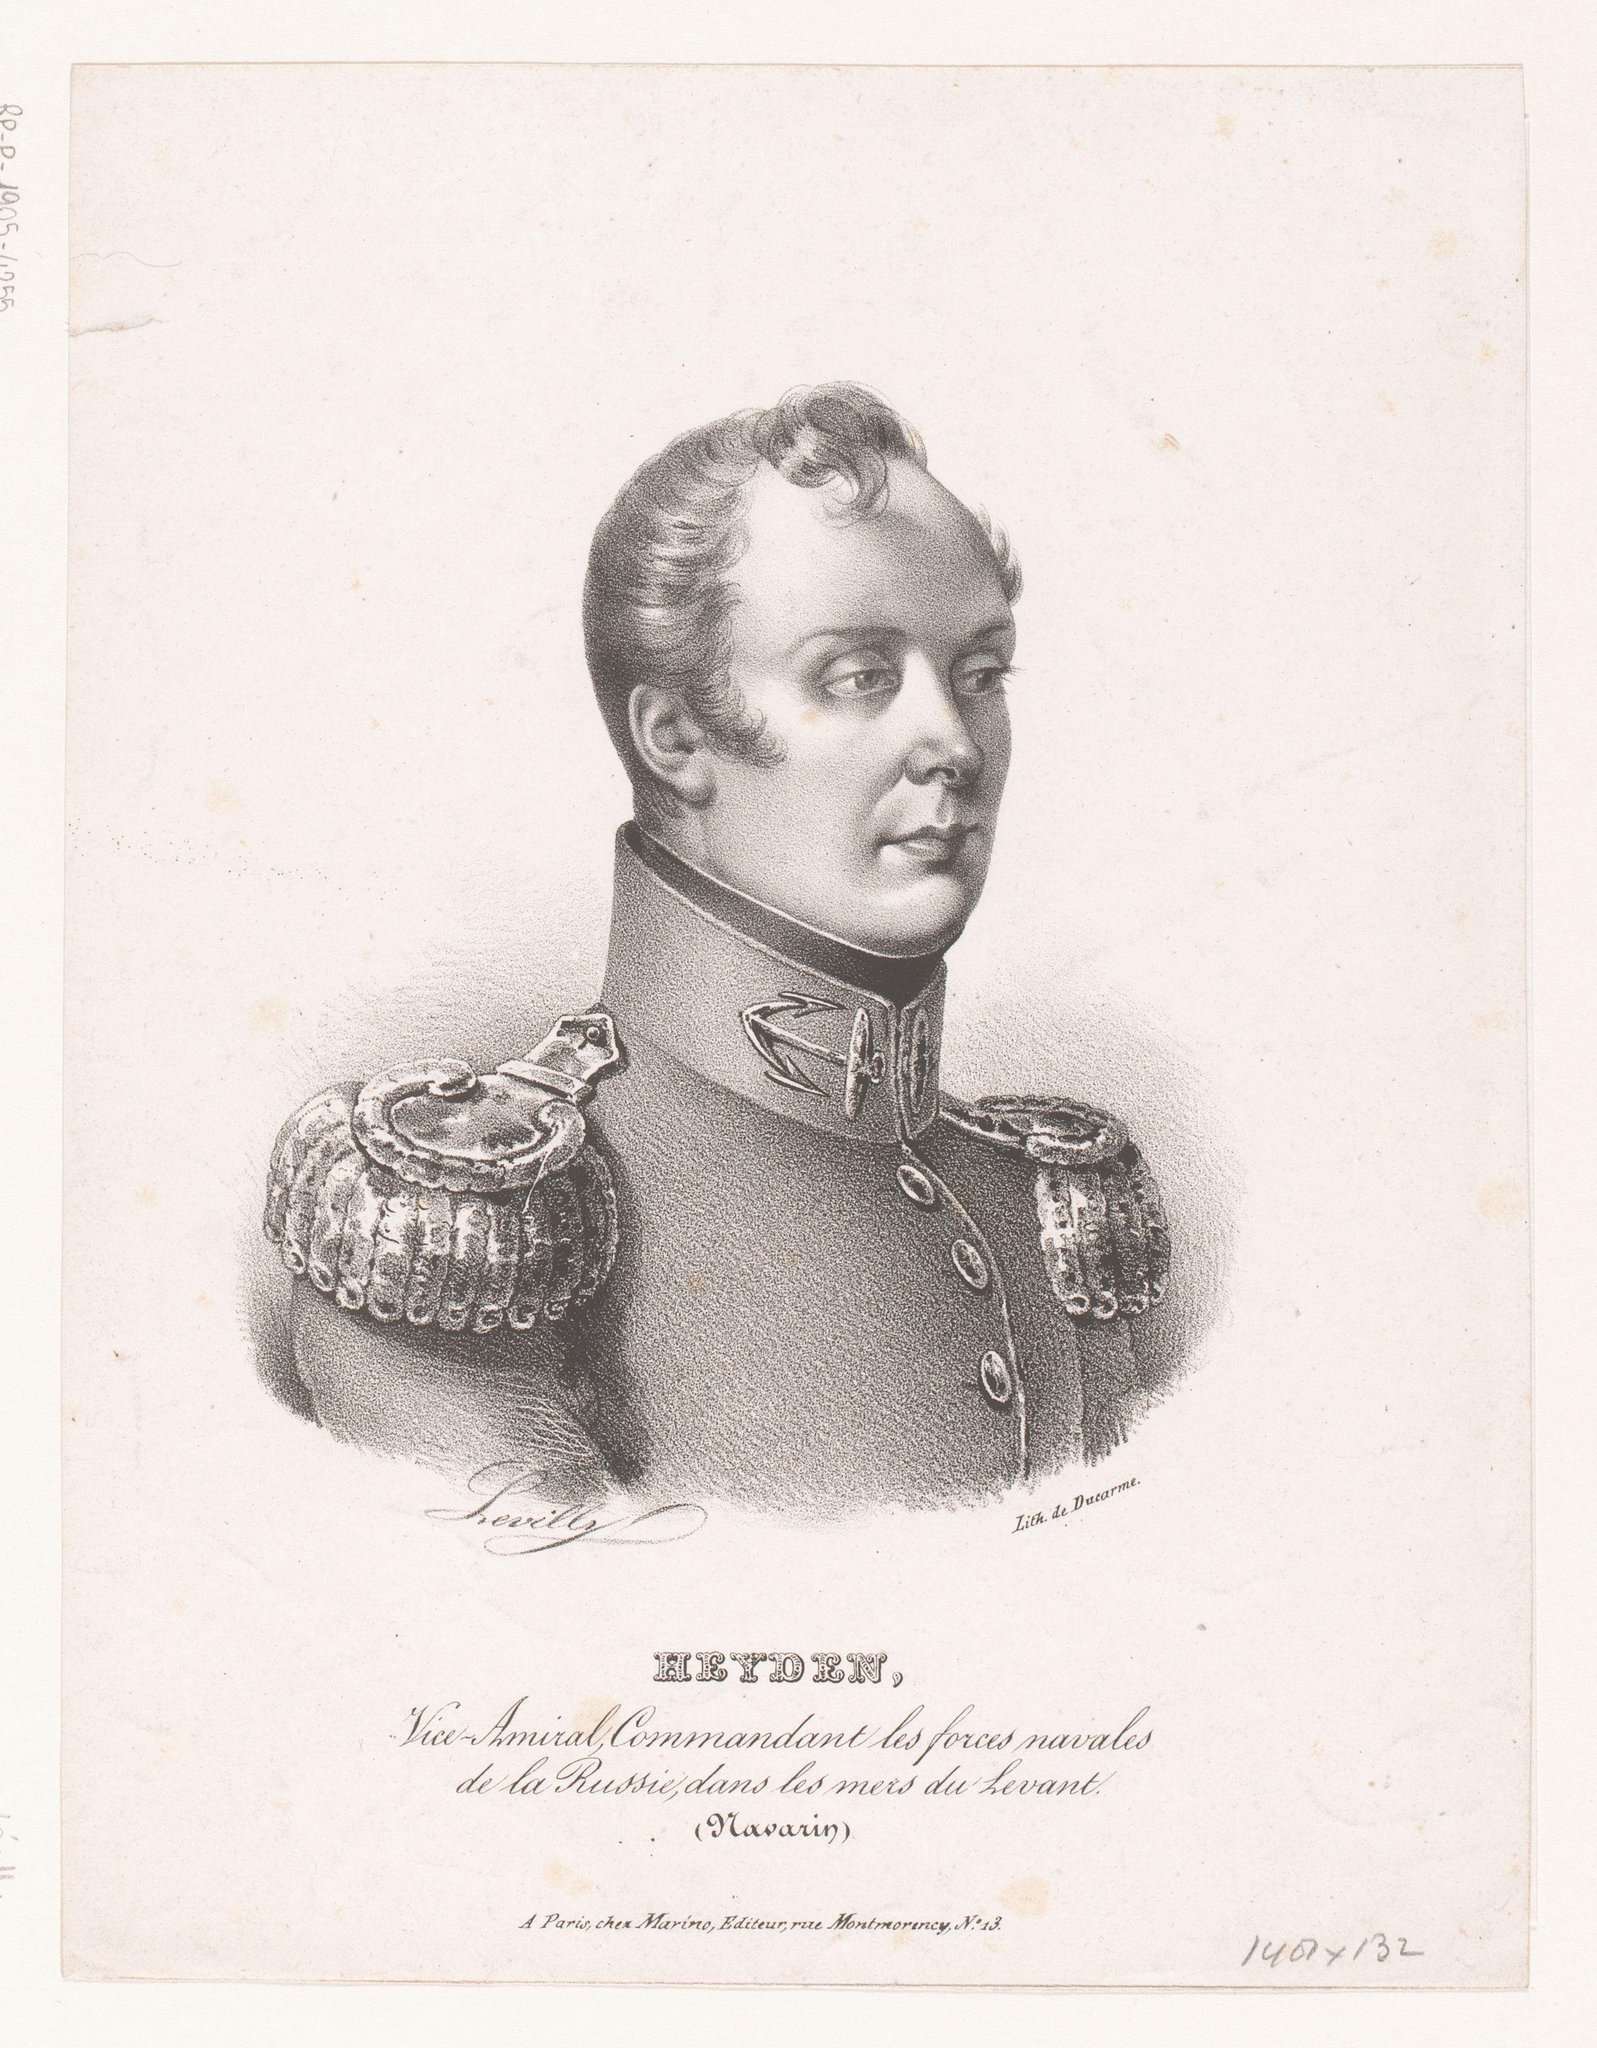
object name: print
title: Portret van commandant Lodewijk van Heiden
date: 1828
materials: paper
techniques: lithograph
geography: paris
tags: the hague, historical persons, (military) uniforms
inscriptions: collector's mark: Lugt 2228